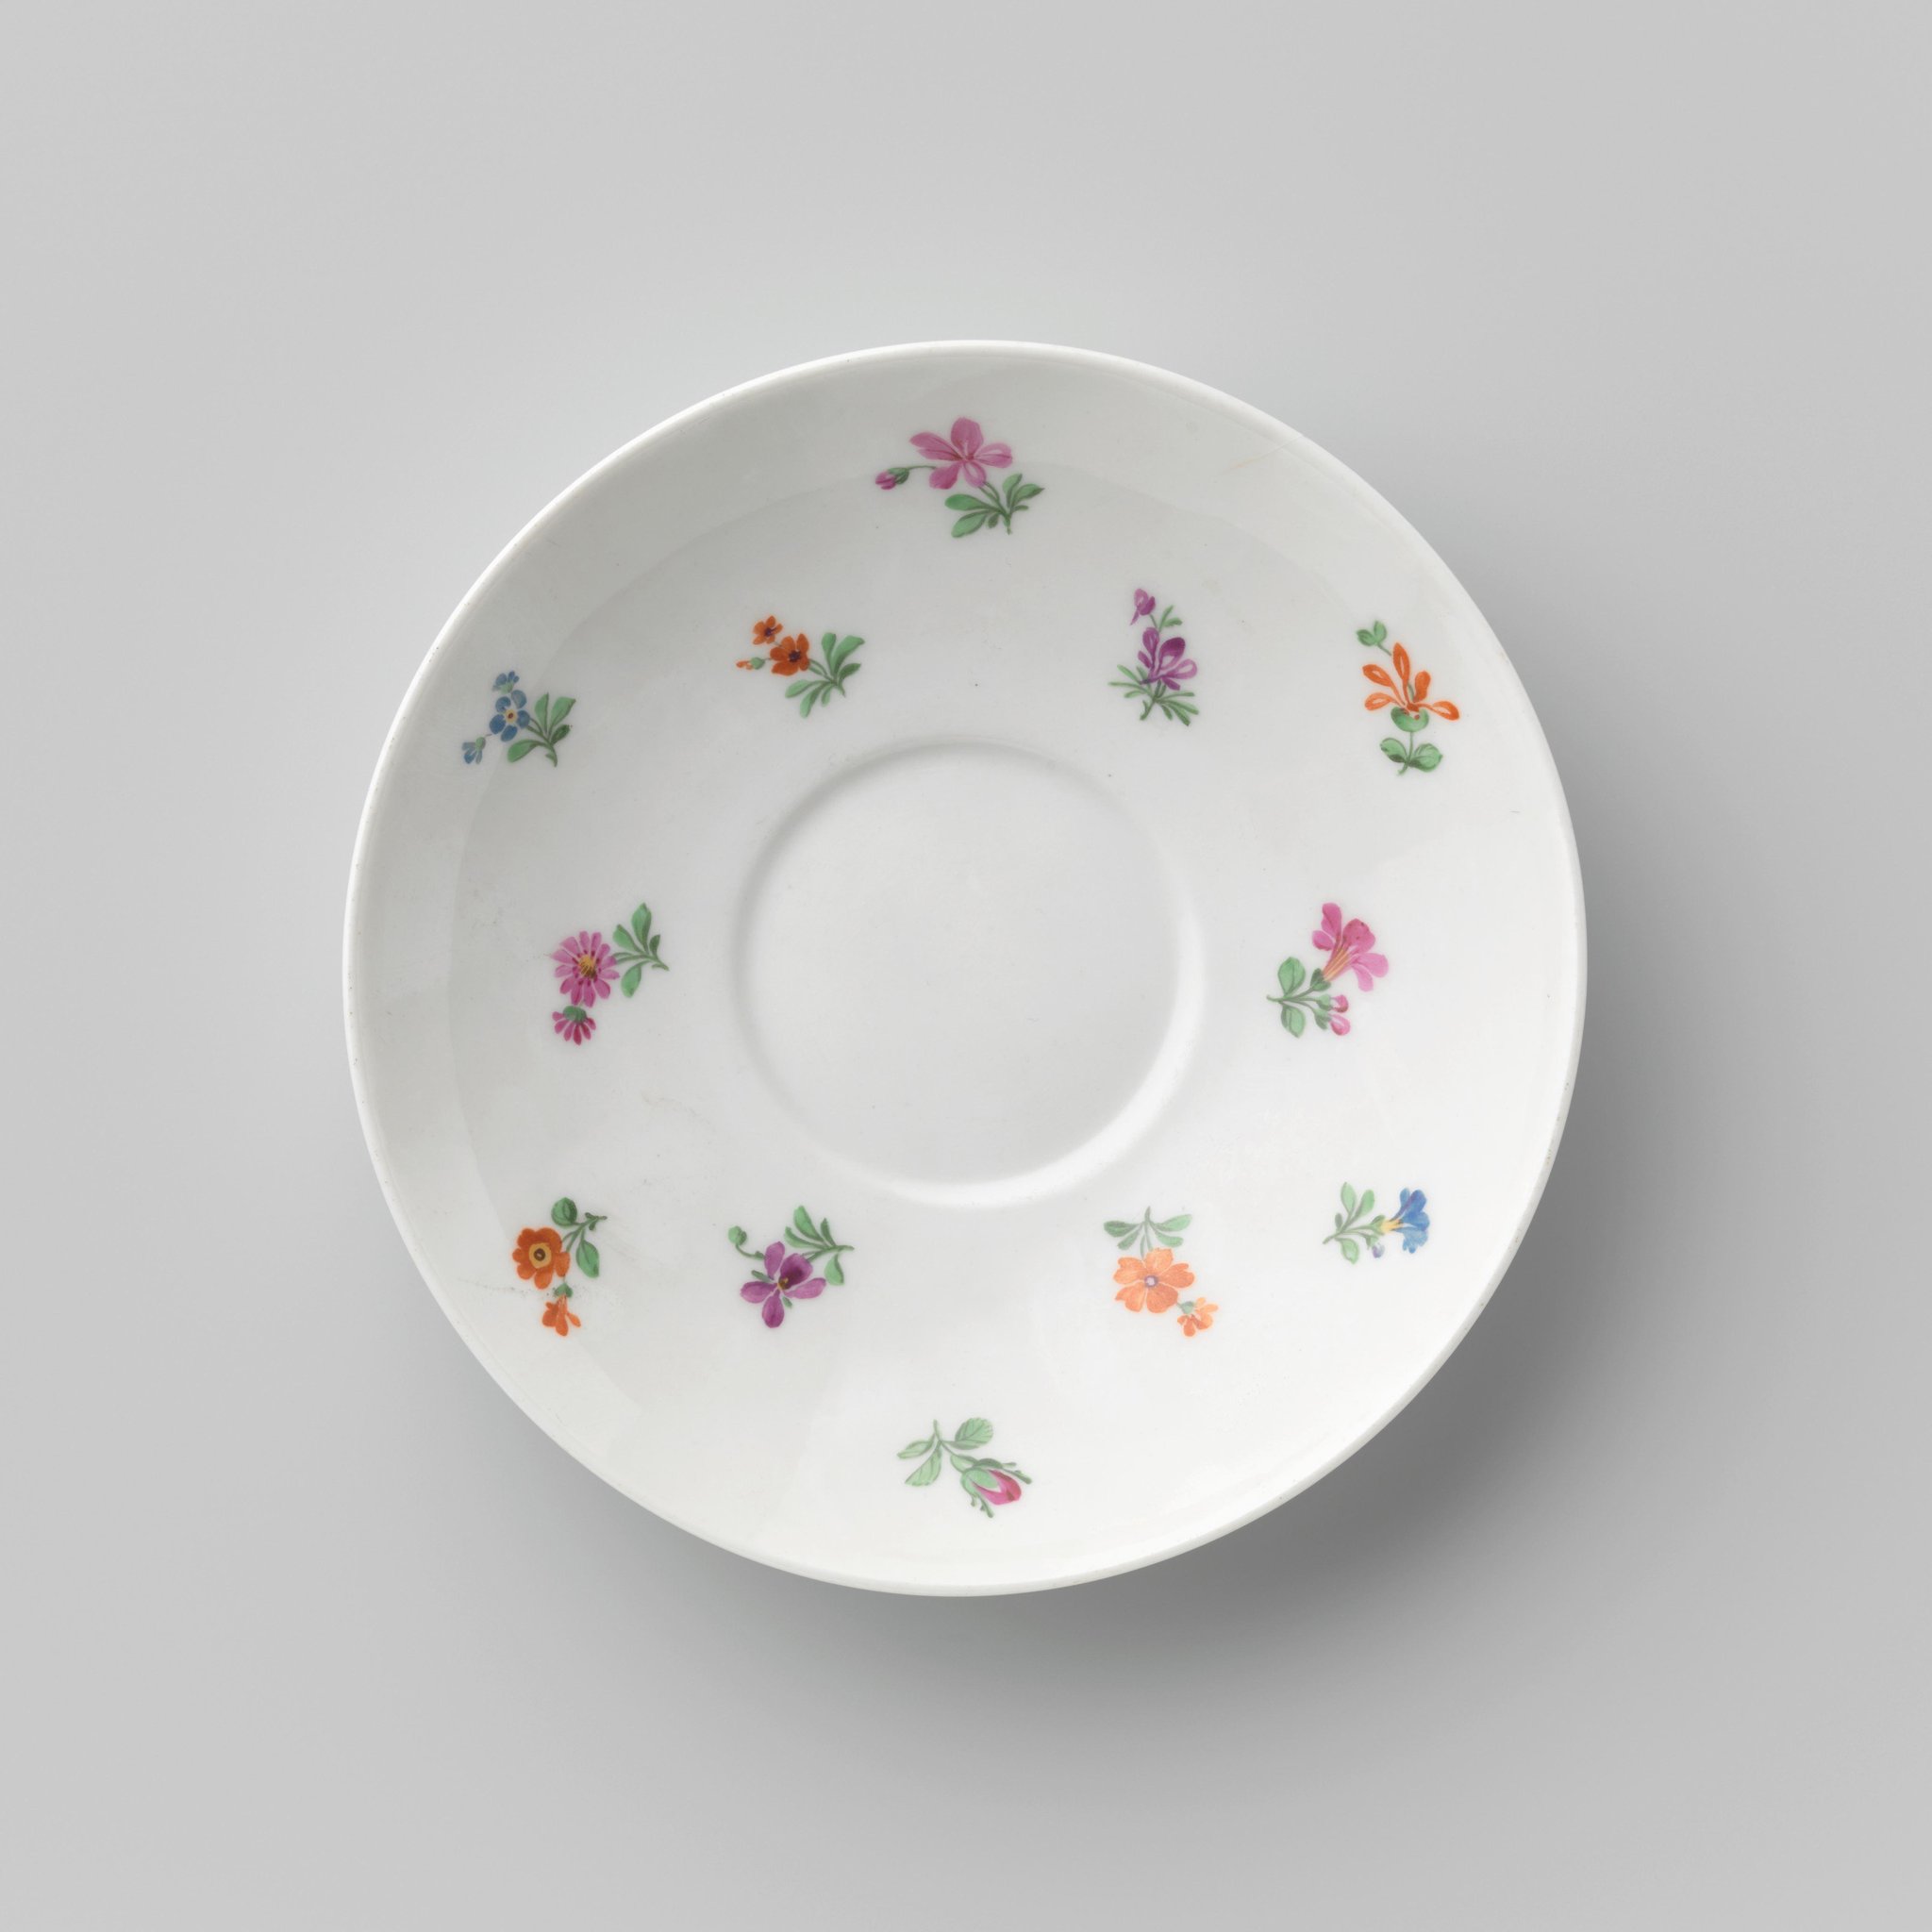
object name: platter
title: Saucer with flowers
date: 1849-1870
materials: glaze, paint, porcelain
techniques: firing, turning, vitrification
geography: berlin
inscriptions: mark: ‘scepter met adelaar in medaillon en KOENIGL. PORZELLAN MANUFAKTUR/ rode rijksappel met K.P.M/ 3/ I’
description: Schotel van porselein, beschilderd op het glazuur in blauw, rood, roze, groen, geel, paars en zwart. De binnenwand is bedekt met kleine strooibloemen. De achterzijde is ongedecoreerd. Gemerkt op de onderzijde met de scepter waaronder een medaillon met de adelaar, een scepter en een globe in zijn klauwen. Het randschrift leest 'KOENIGL. PORZELLAN MANUFAKTUR'. Hieronder de rode rijksappel met K.P.M en het nummer 3 en I.